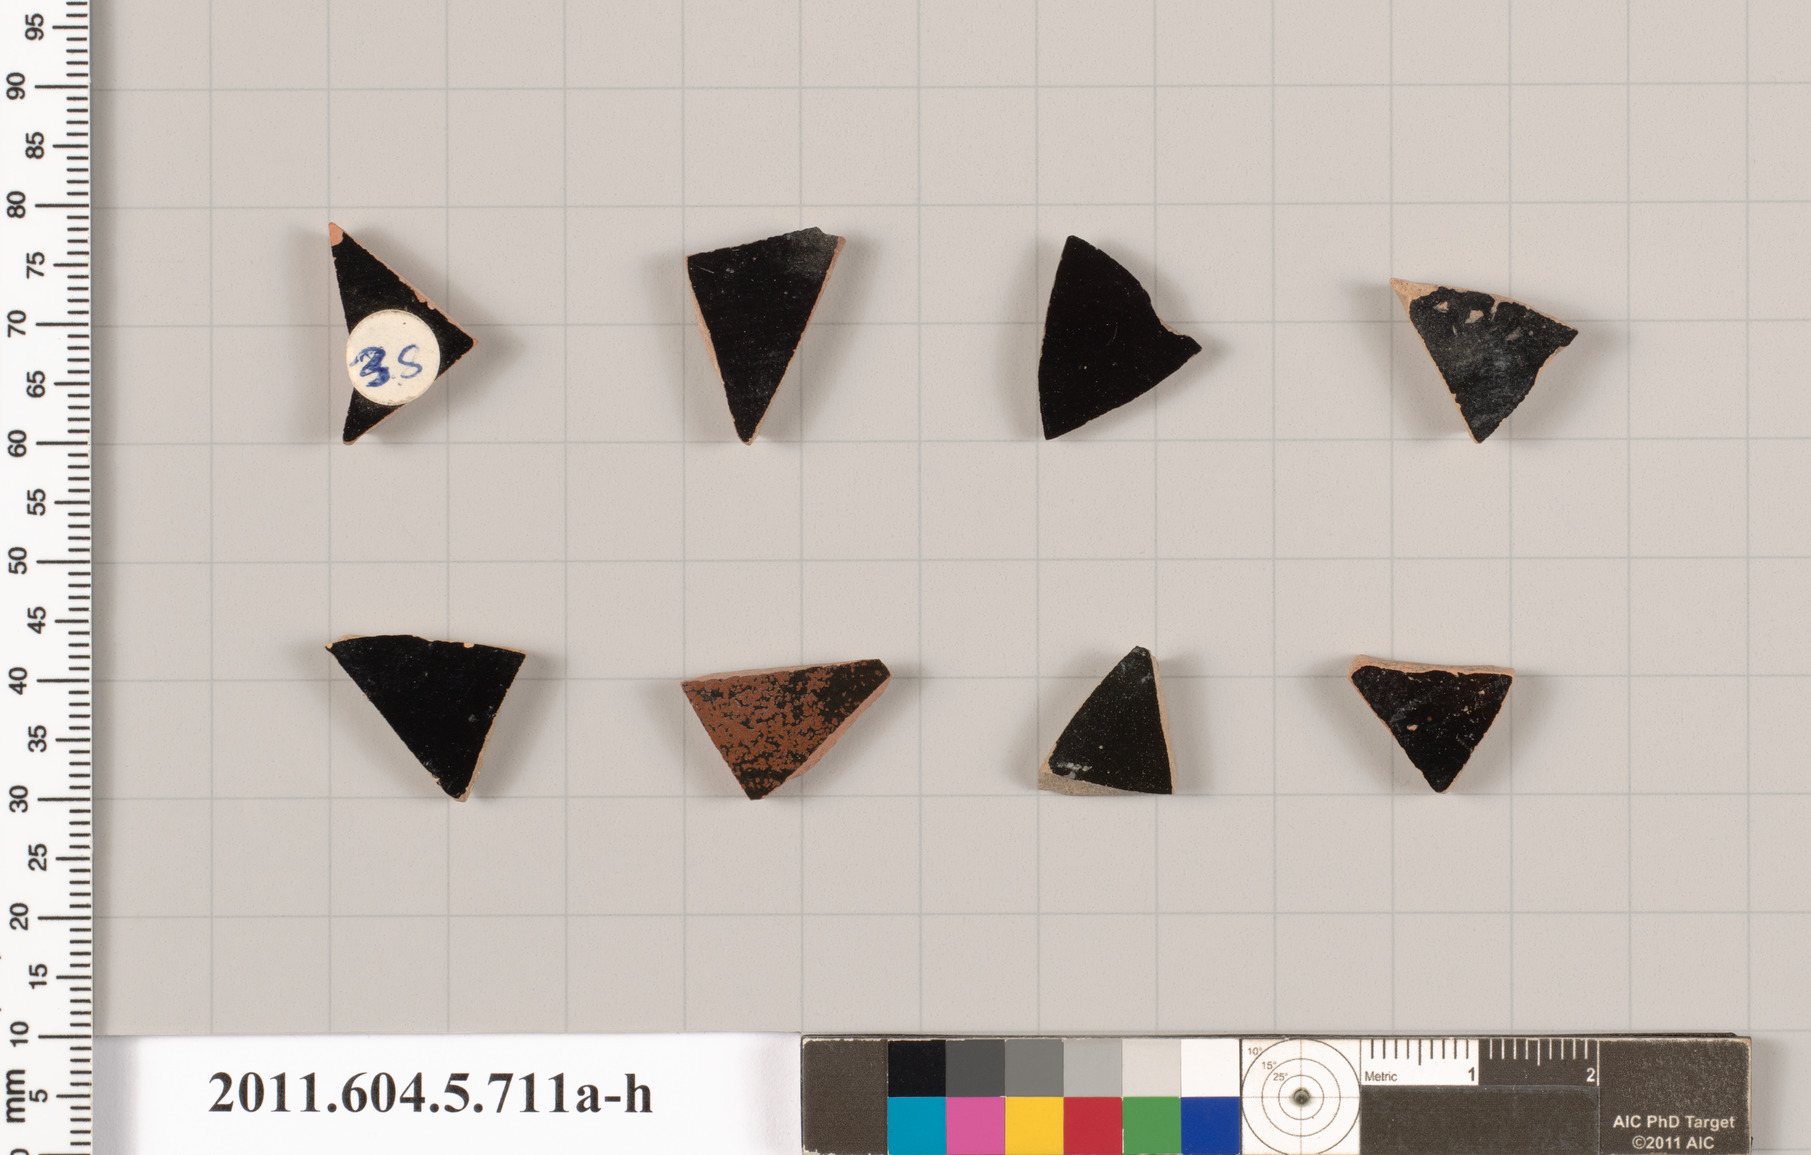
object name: kylix fragment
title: Terracotta fragments of kylikes (drinking cups)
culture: greek, attic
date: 600-401 BCE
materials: terracotta